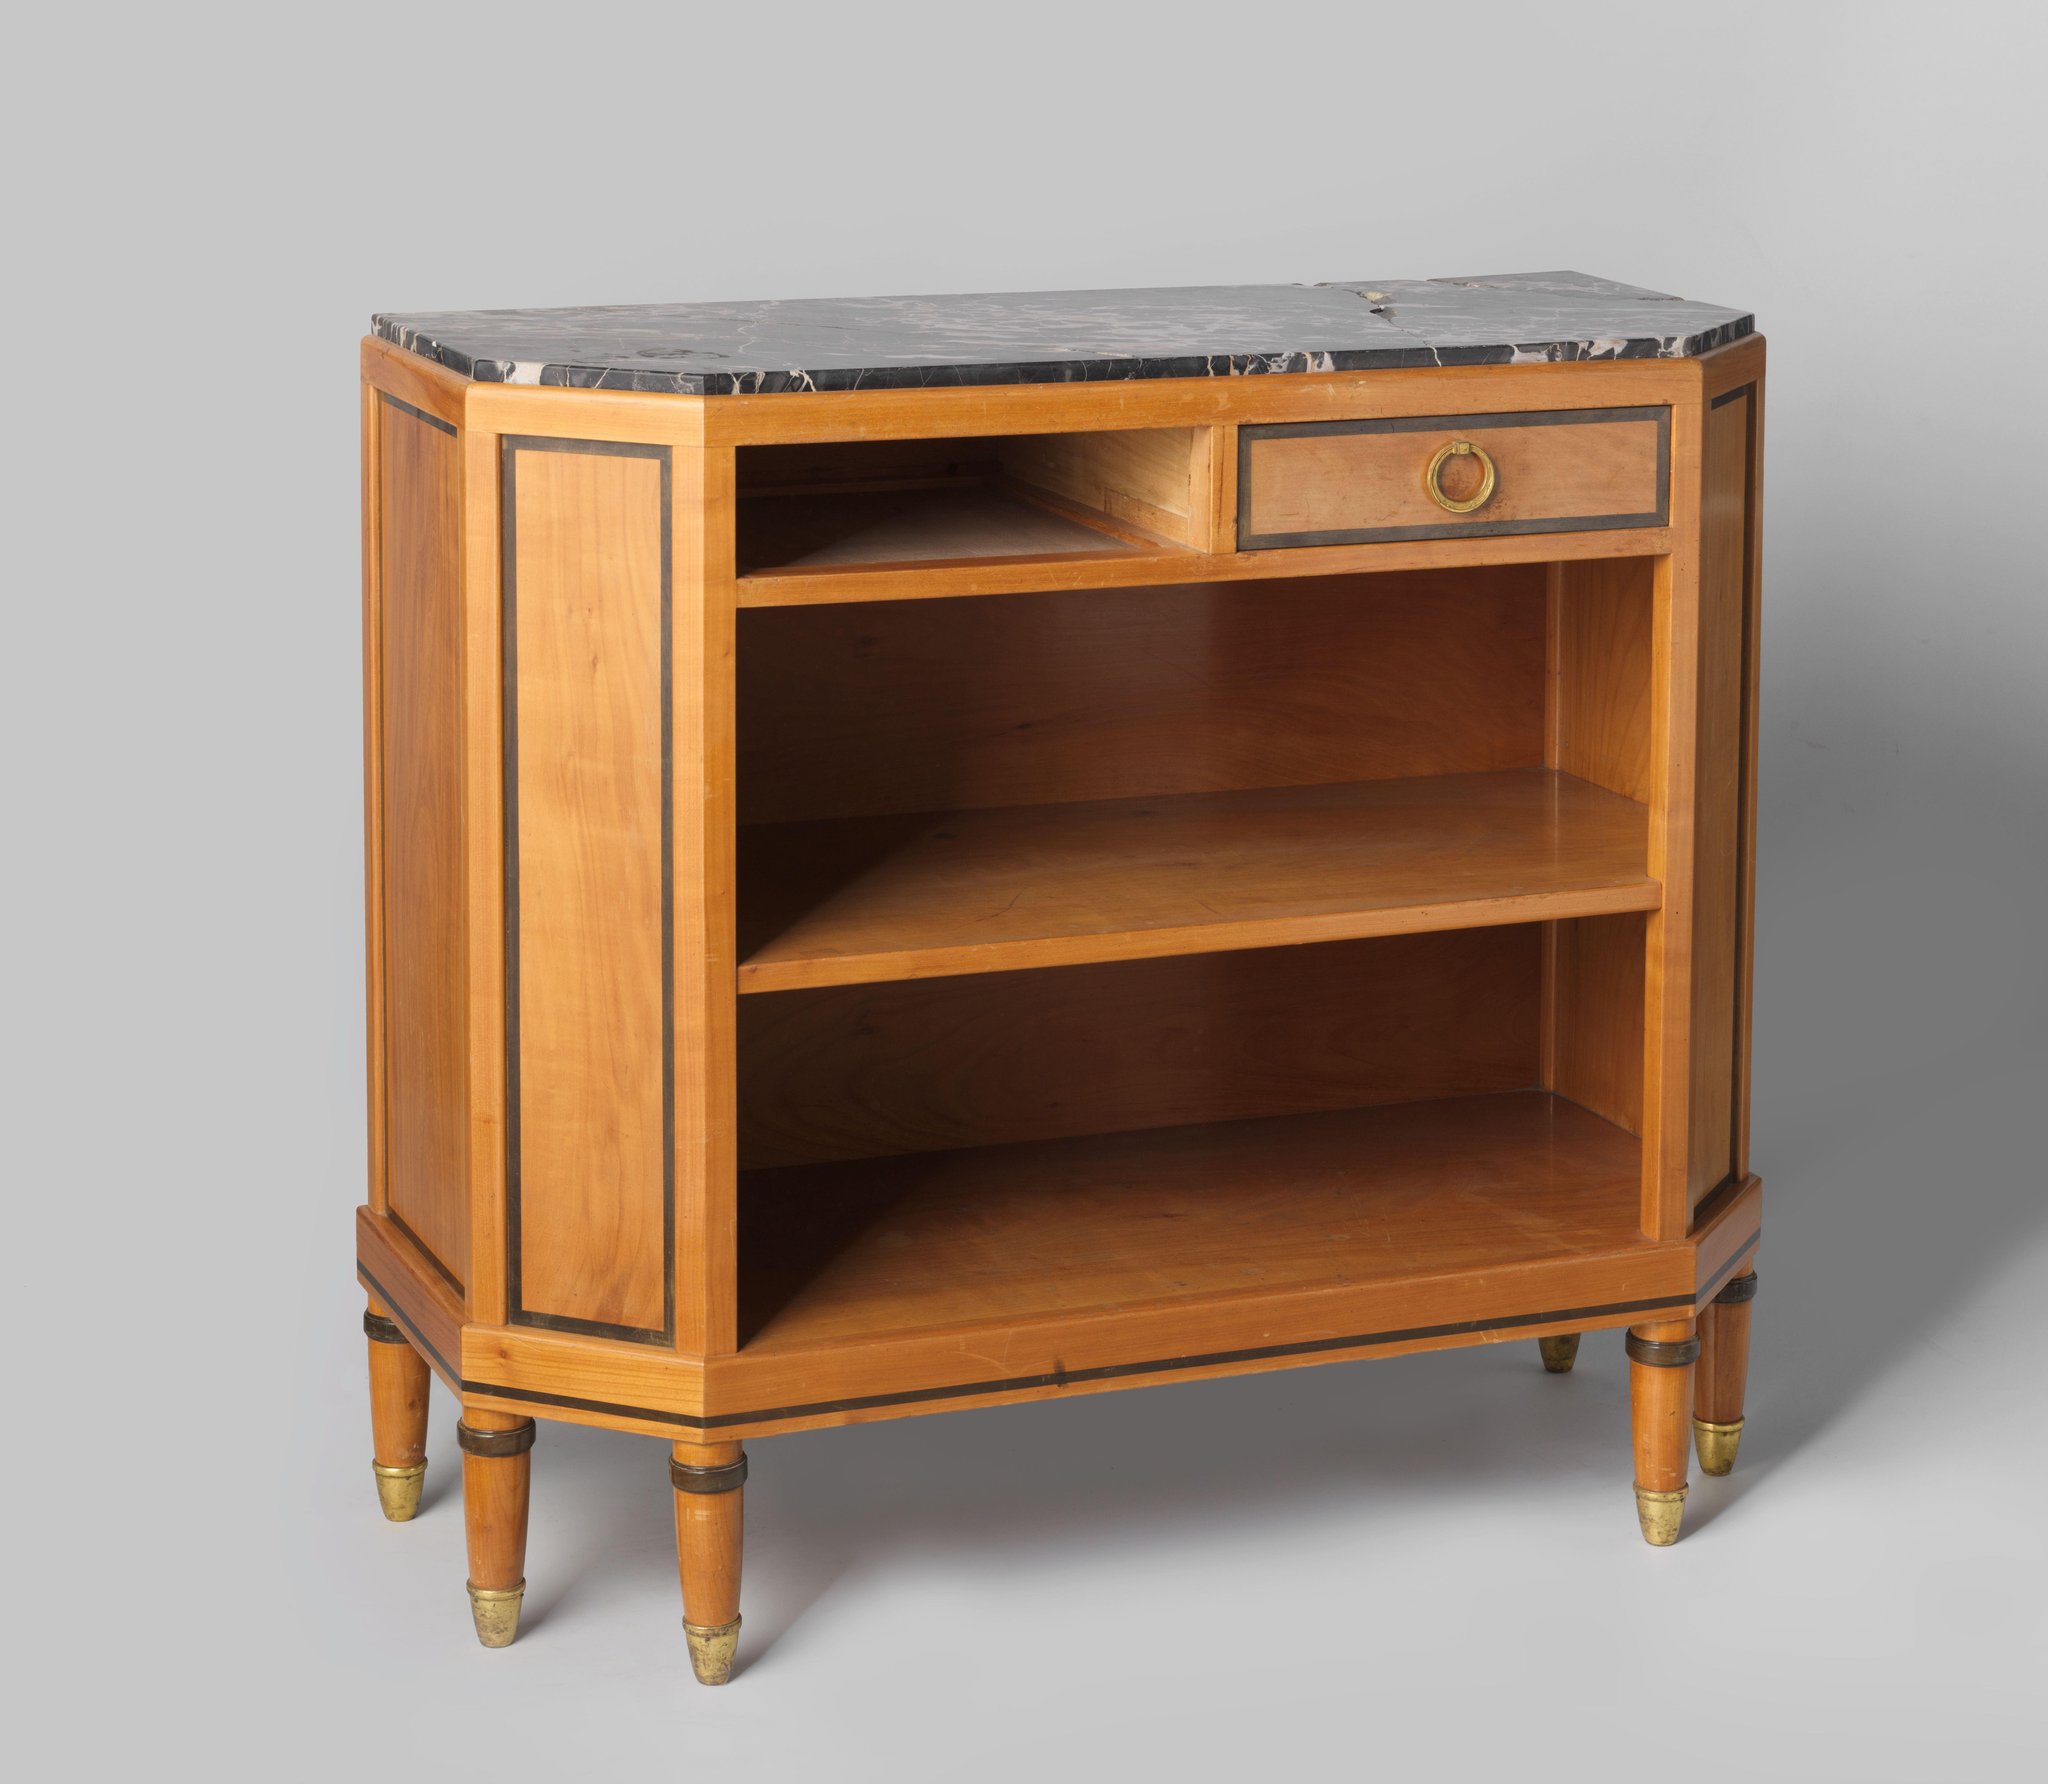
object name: furniture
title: Dressoir met twee planken en daarboven laden omrand met zwarte biezen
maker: Anonymous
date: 1900-1925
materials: brass, wood, marble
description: Dressoir vervaardigd van vruchtenhout. Het zeskantig dressoir heeft afgeschuinde hoeken aan de voorzijde rust op zes hoge poten onder elke hoek. De gedraaide poten, met aan de onderzijde een messing omhulsel, verbreden naar boven en hebben aan de bovenzijde een zwart geverfde band. Vijf zijden, behalve de achterzijde, bestaan uit een raamwerk met een paneel omgeven door een zwart geverfde bies. De voorzijde bevat twee planken boven elkaar met daarboven twee laden naast elkaar. De randen van de laden zijn omgeven door een zwart geverfde bies en bevatten messing ringen als handgrepen. Op de bovenzijde van het dressoir is een grijs geaderd marmeren blad ingelaten.